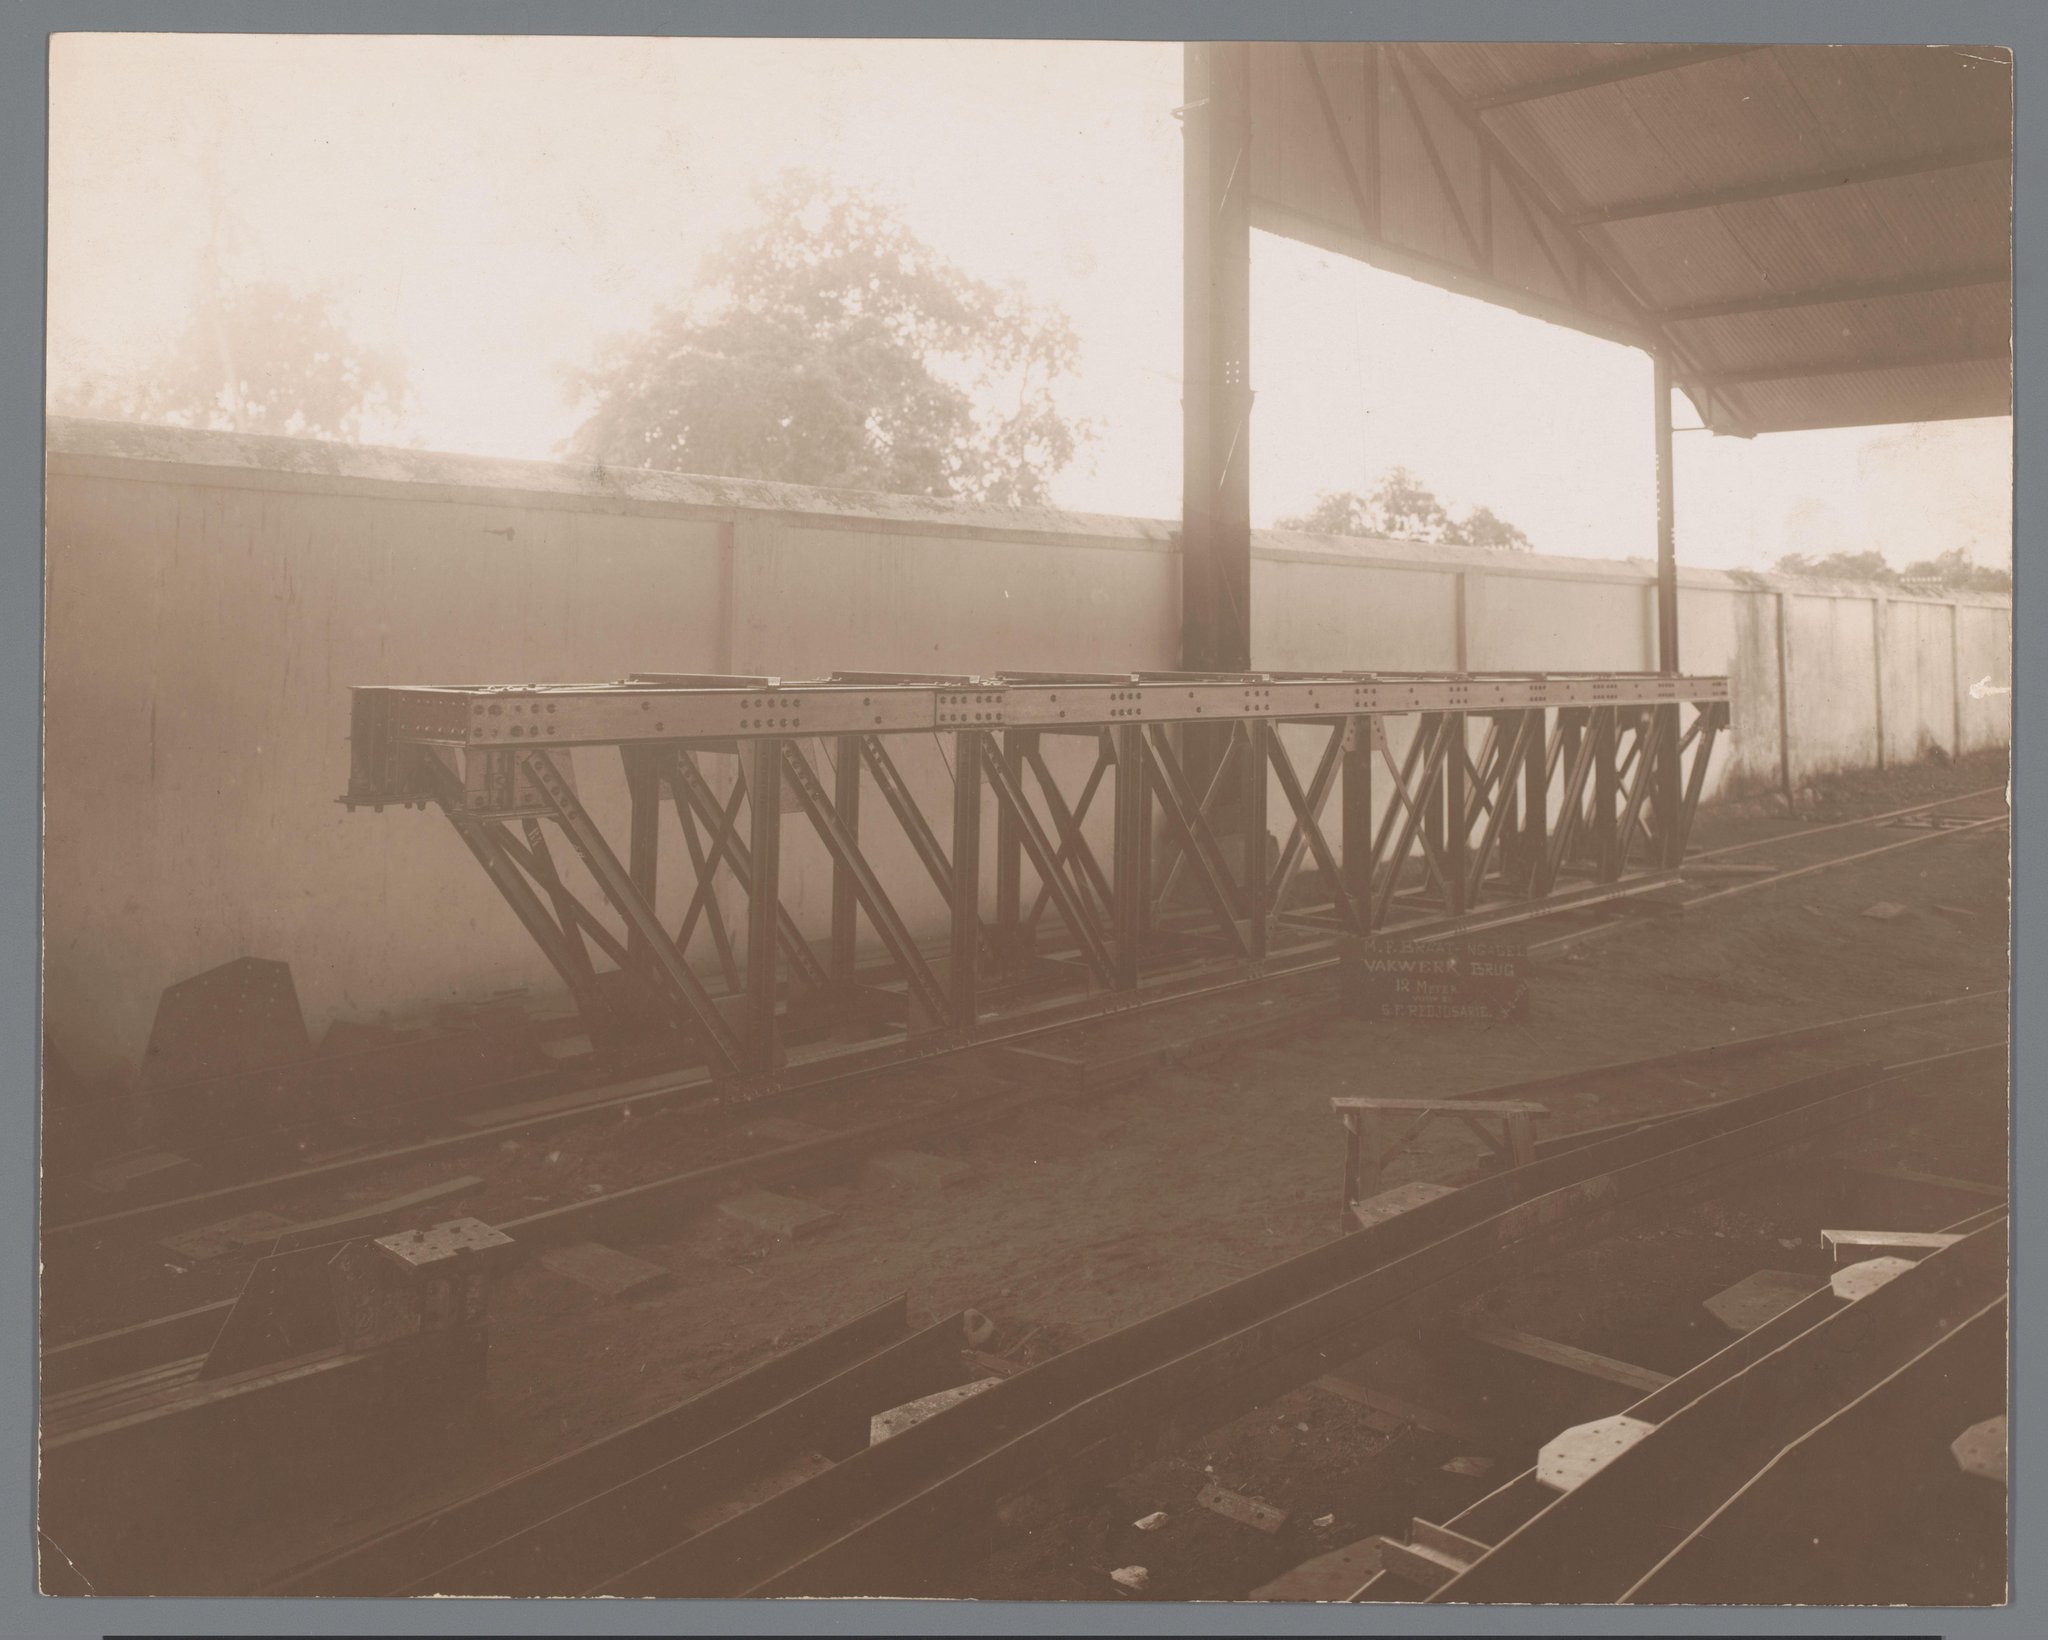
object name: photograph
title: Vakwerkbrug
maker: Anonymous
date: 1923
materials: photographic support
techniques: gelatin silver print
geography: surabaya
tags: colonial system, factory-interior, machine shop, machines; parts of machines; tools and appliances, railway, tramway; rack railway, bridge, java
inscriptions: inscription: ‘Geleverd aan S.F. Redjosarie 1923 door N.V. Mach. Fabr. "Braat" Soerabaia Or. 1011 20 Tons Vakbergbrug met bovengelegen rijvlak voor Locomotief verkeer / Spanning 12 M.’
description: Deel van een vakwerkbrug met een bovengelegen rijvlak voor treinverkeer en een spanning van 12 meter. Vervaardigd in 1923 en bestemd voor de Suikerfabriek Redjosarie. Onderdeel van een groep van losse, grotere foto's van verschillende soorten machines van de N.V. Machinefabriek Braat te Soerabaja, uit de periode ca. 1920-1940.